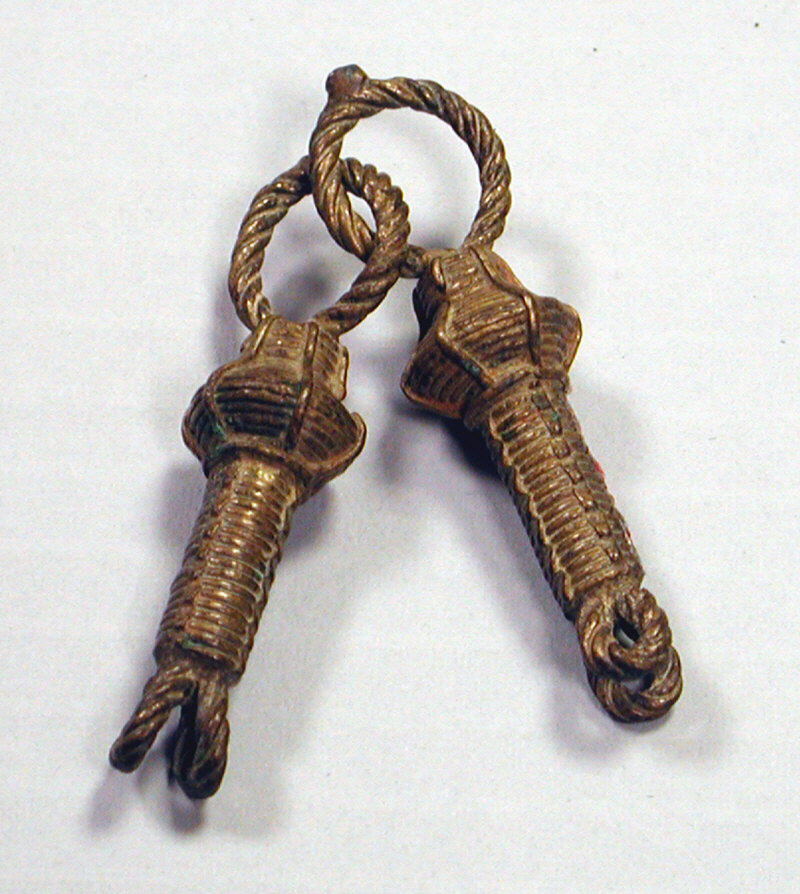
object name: weight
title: Gold Weight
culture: akan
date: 1701-1900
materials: brass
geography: ghana